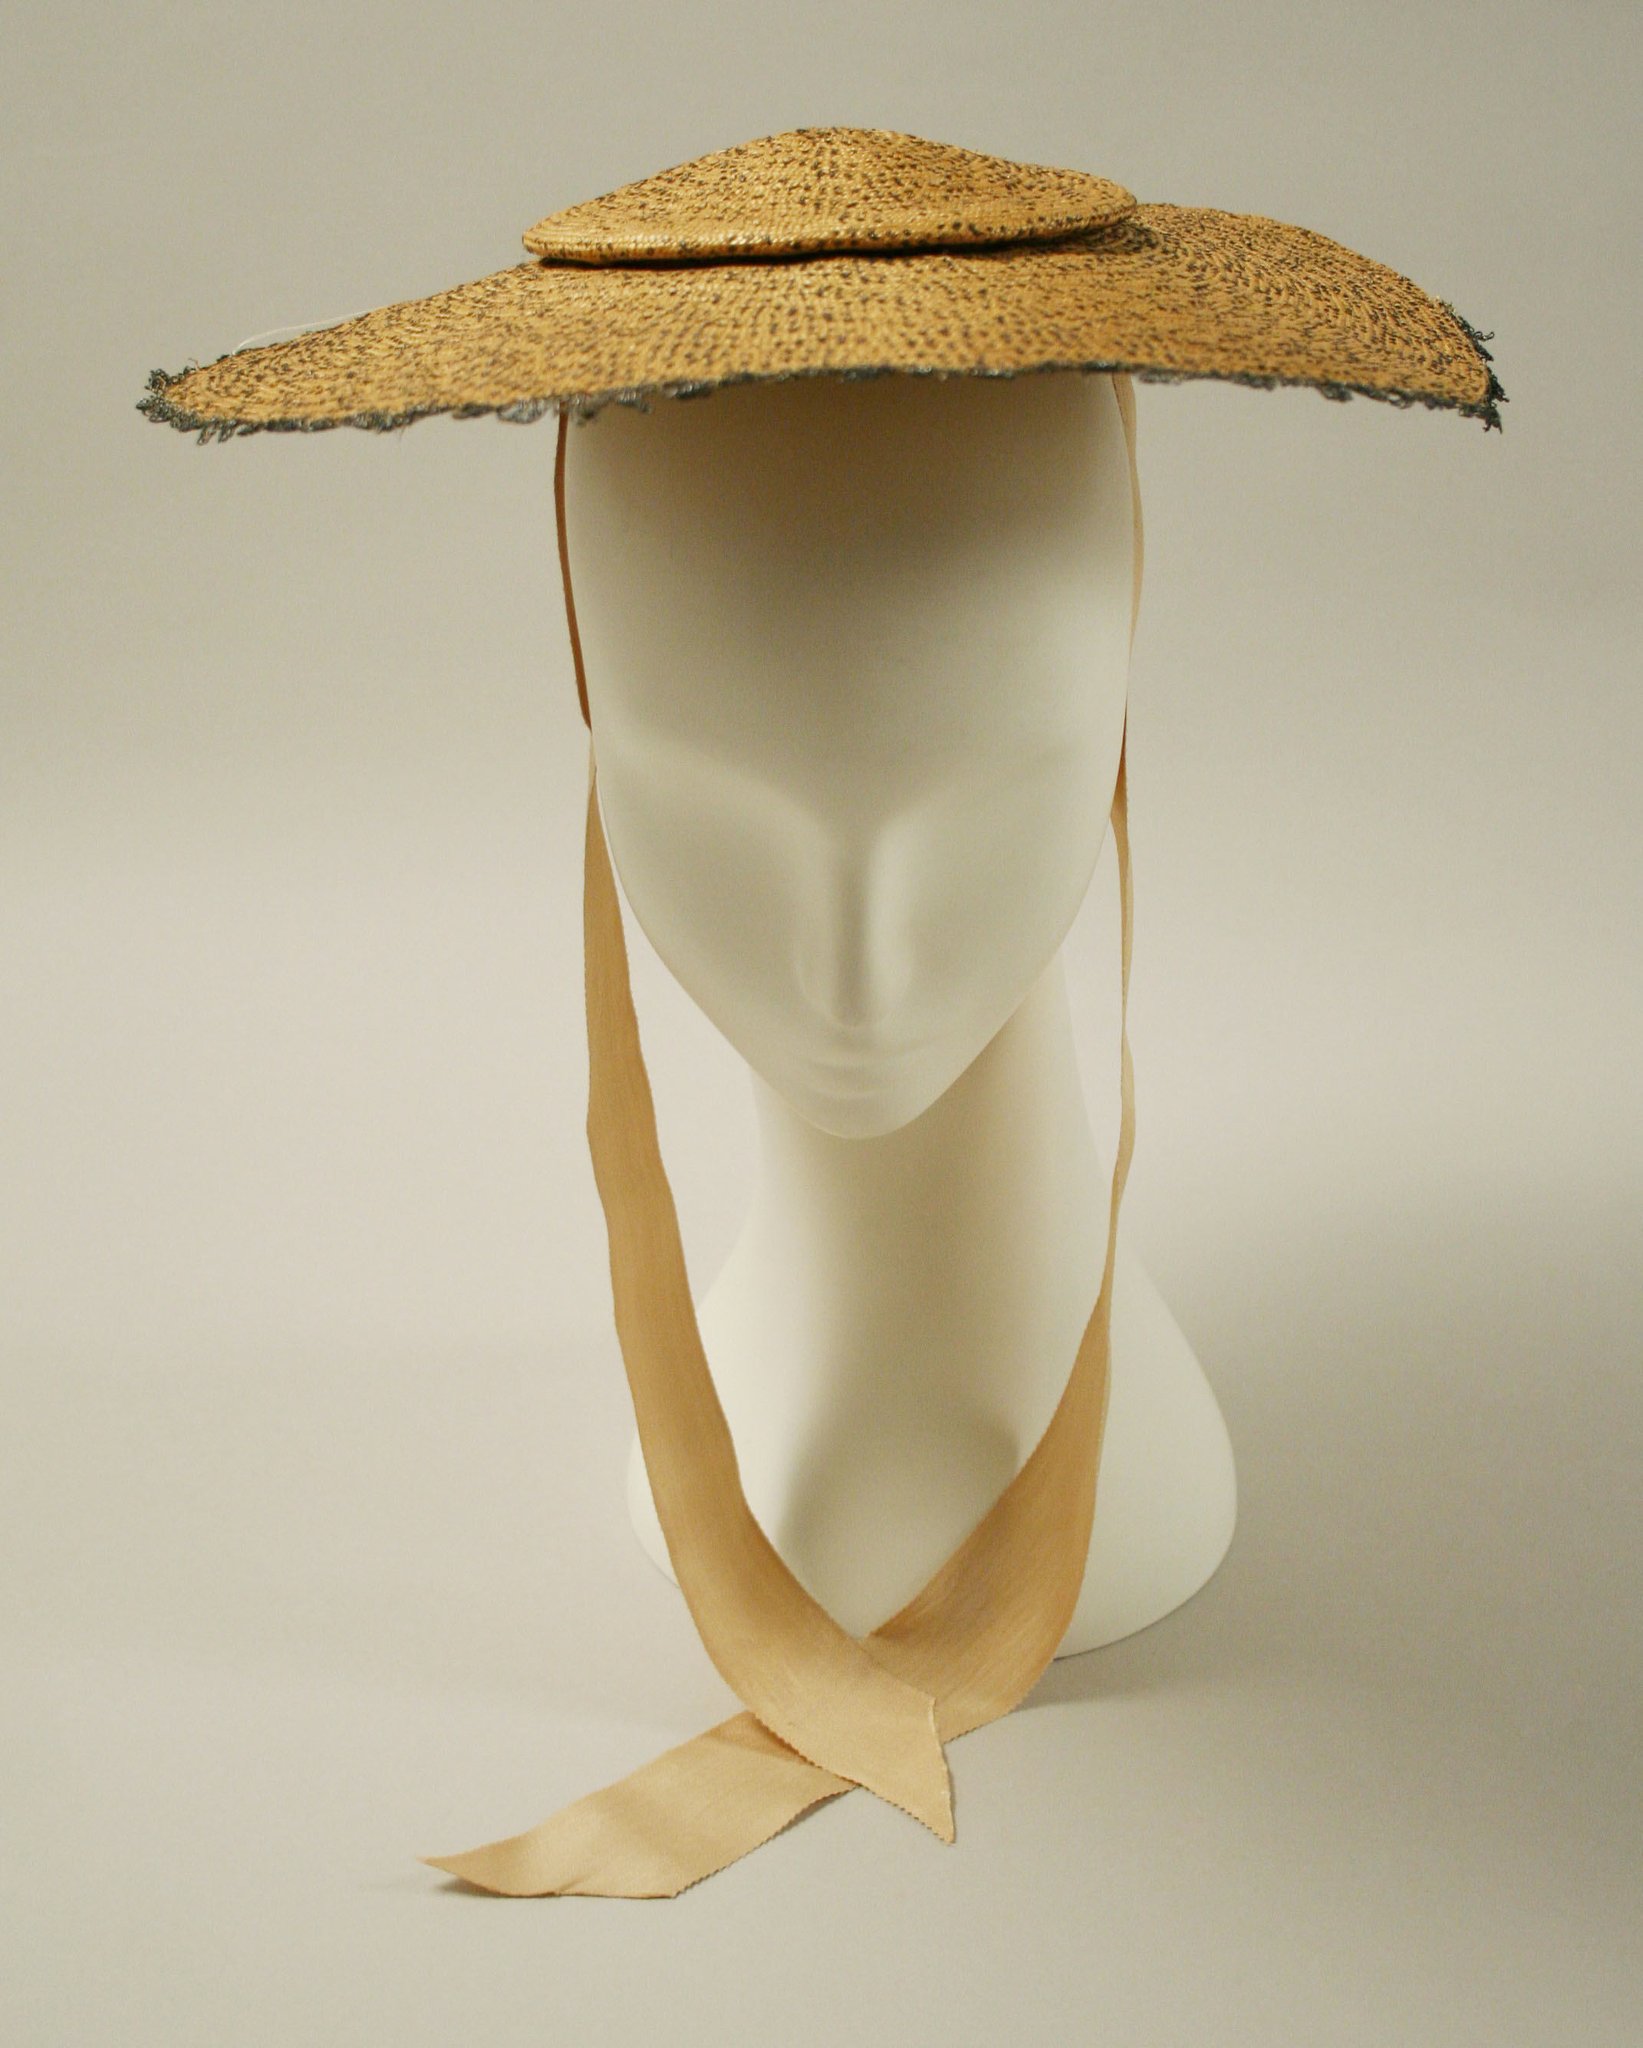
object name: bergère hat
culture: british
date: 1701-1800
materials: fiber